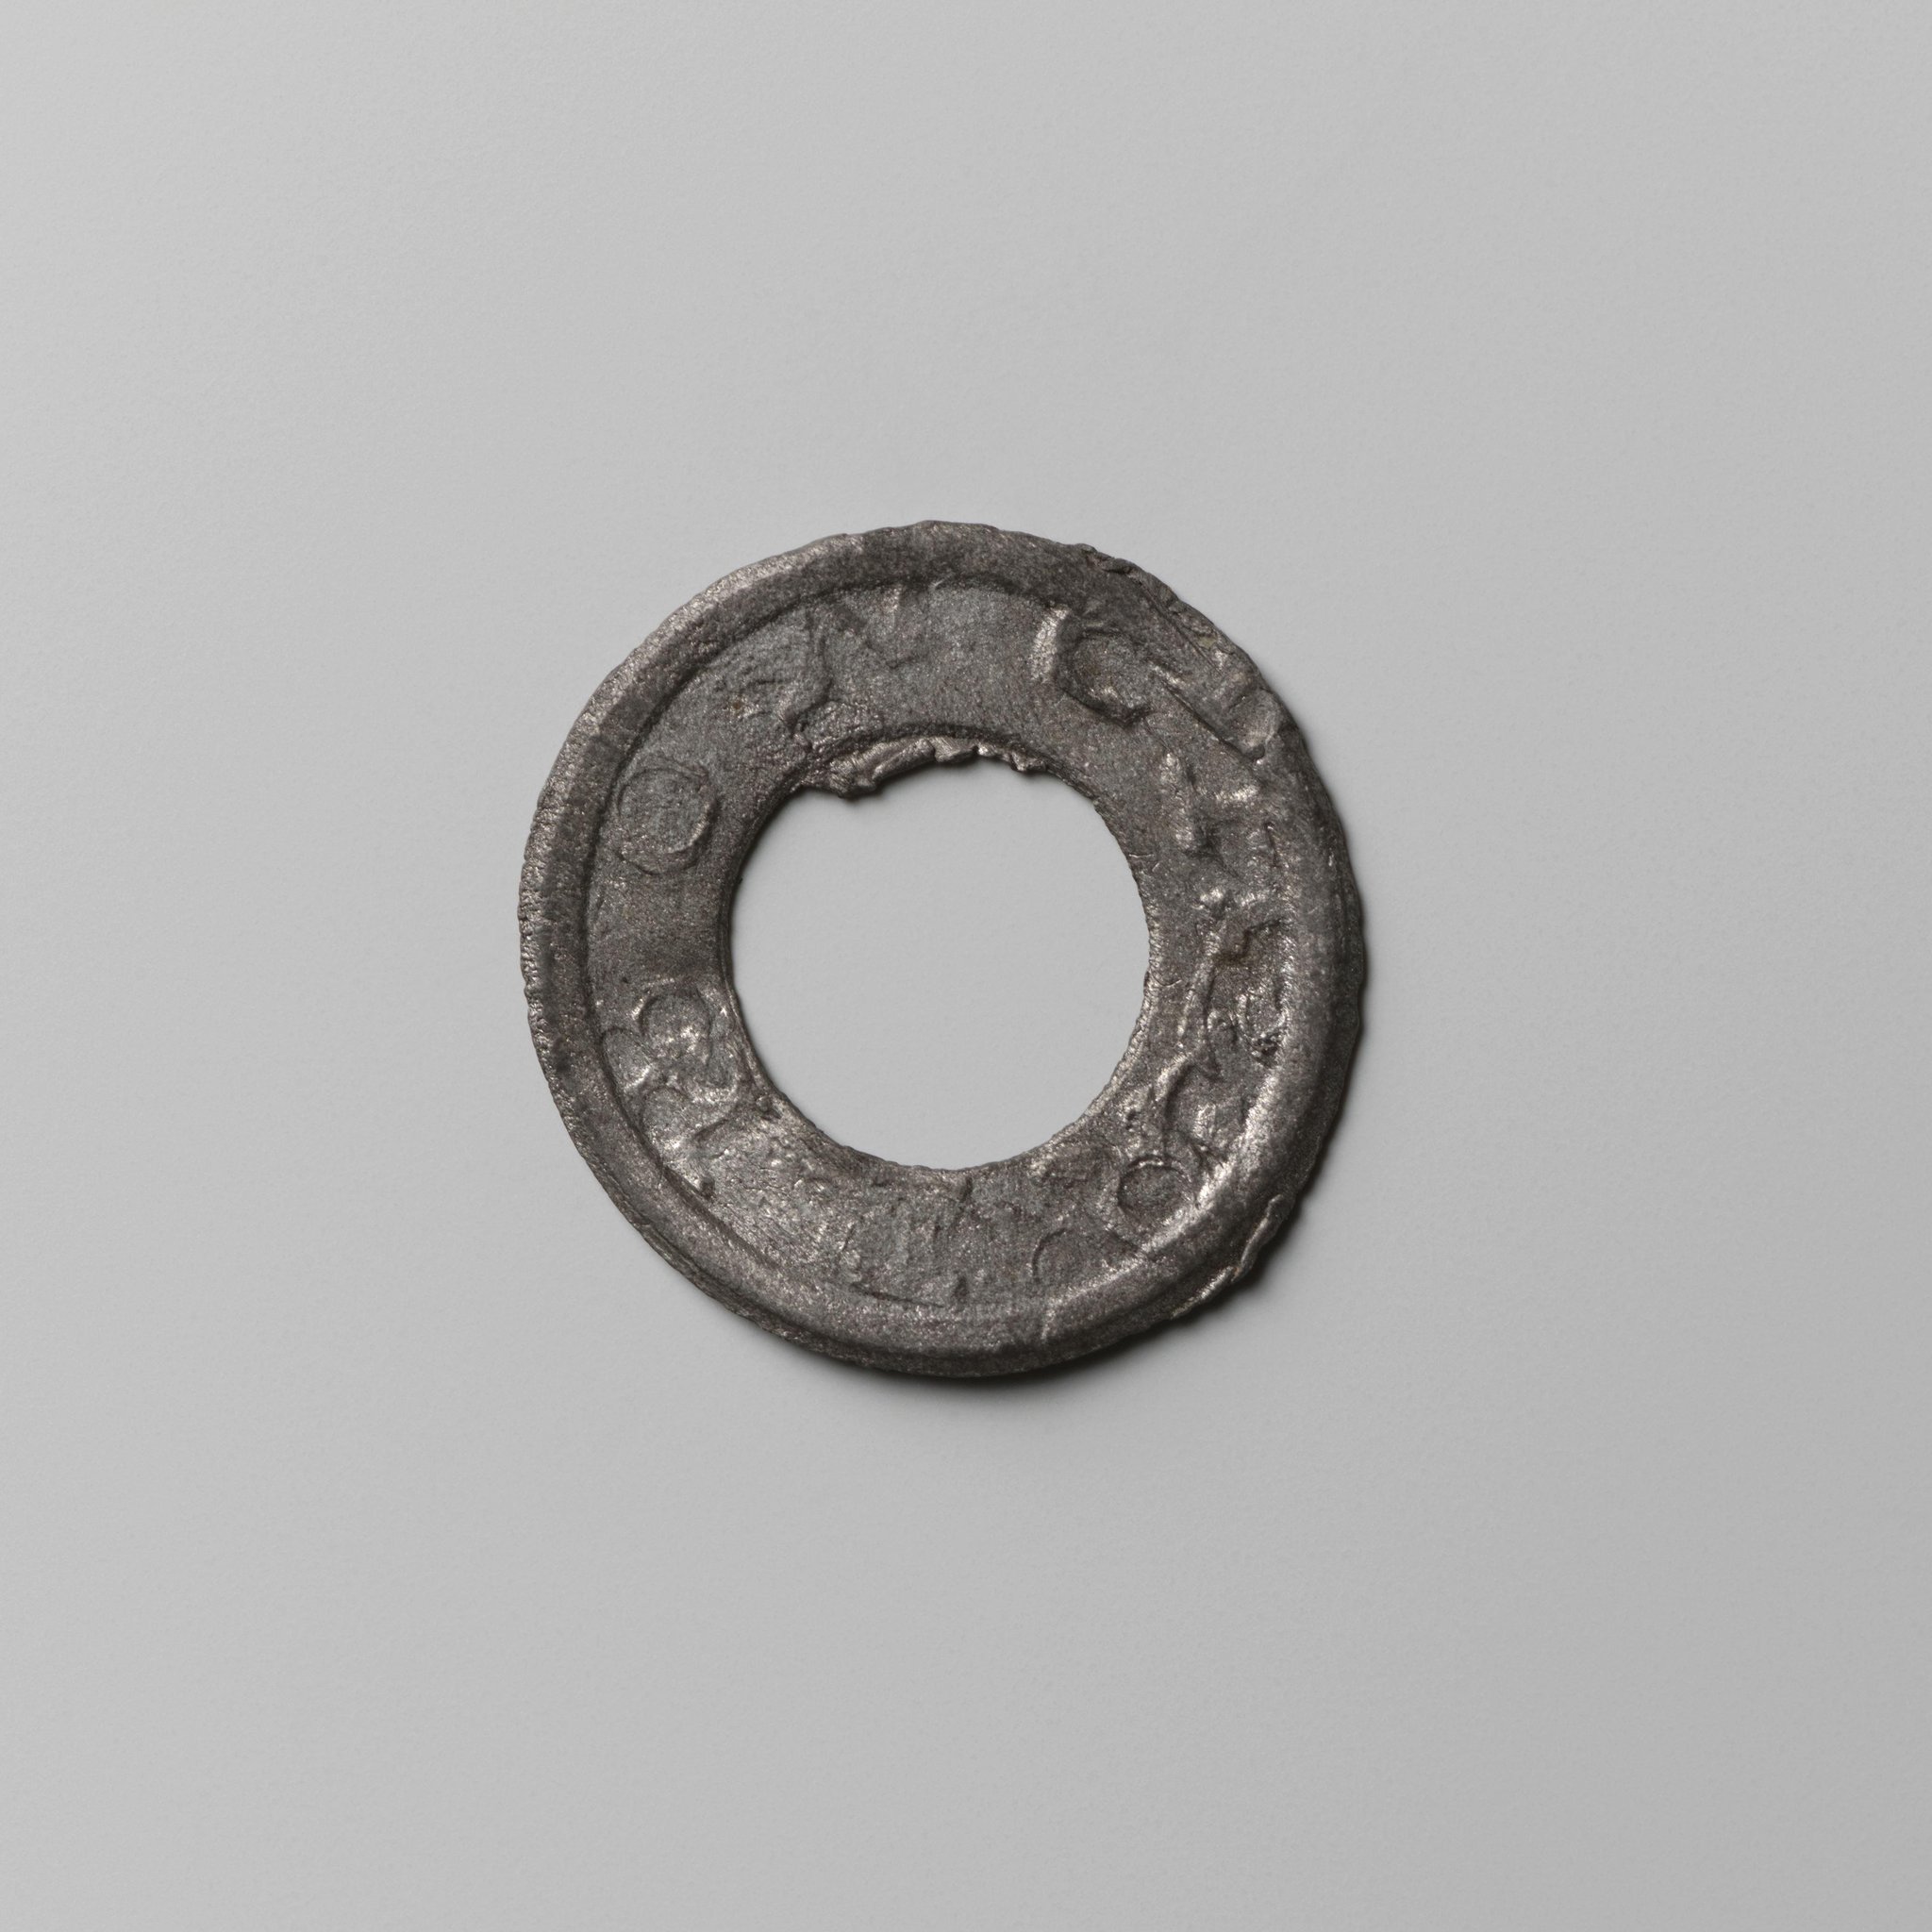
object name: coin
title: Djambi, Sumatra, pitji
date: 1700-1850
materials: tin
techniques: casting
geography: djambi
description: Tinnen munt. Voorzijde: omschrift in Javaanse (?) lettertekens. Keerzijde: glad. In het midden bijna rond gat.